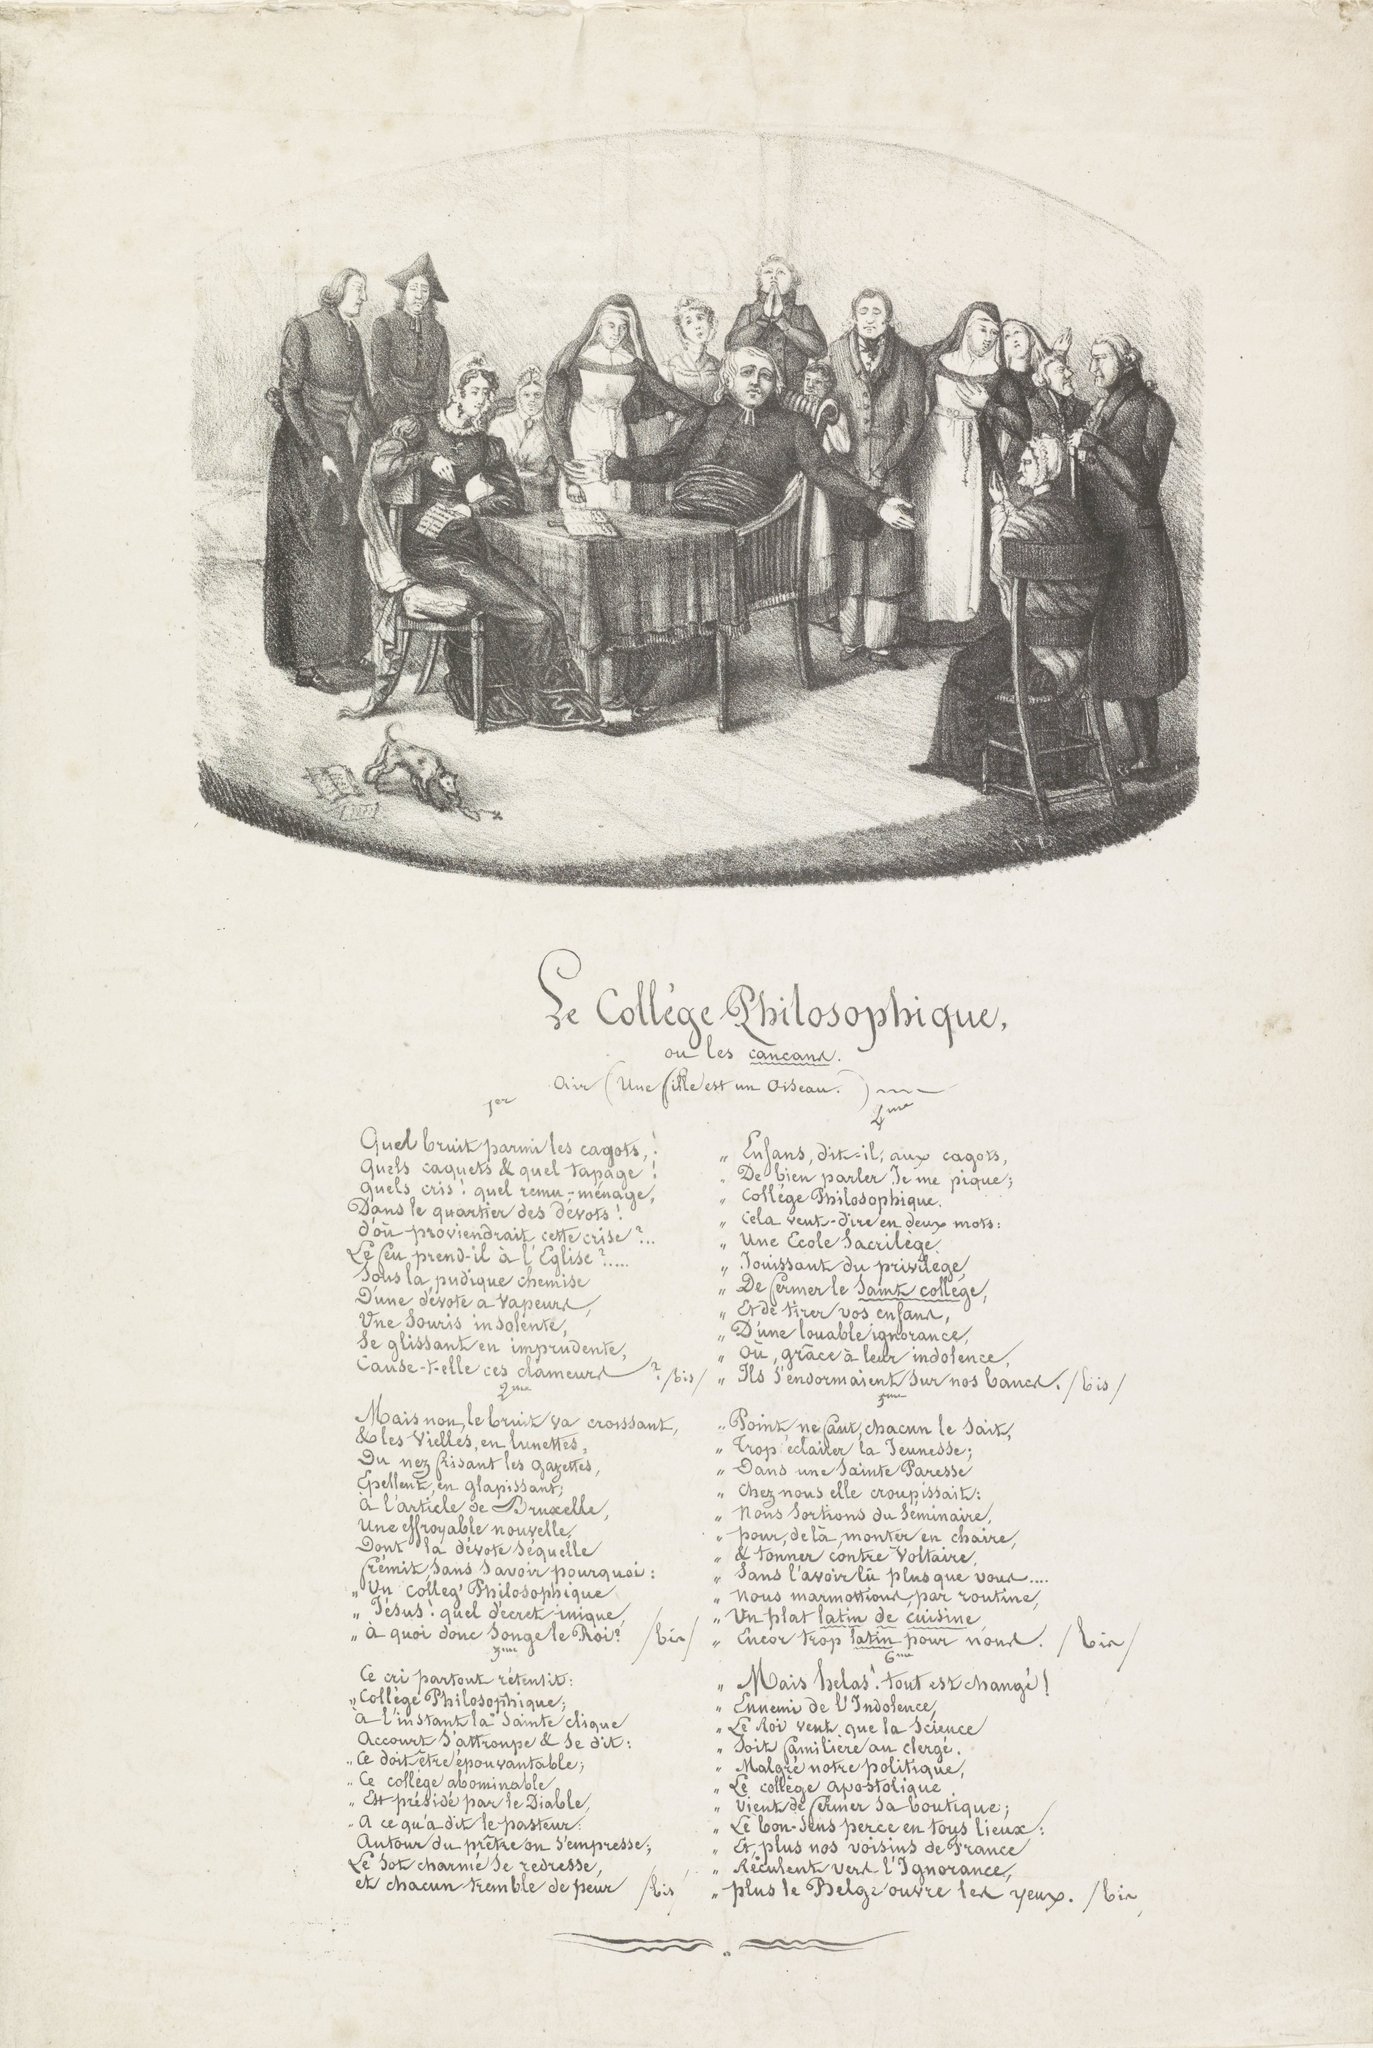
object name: print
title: Le Collège Philosophique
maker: Anonymous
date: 1825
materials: paper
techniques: lithograph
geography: southern netherlands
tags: berlin, william i of the netherlands, archbishop, bishop, etc. (roman catholic), louvain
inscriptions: collector's mark: Lugt 2228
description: Spotprent op de oprichting bij Koninklijk Besluit van 14 juni 1825 van het Collegium Philosophicum te Leuven, voor de opleiding van rooms-katholieke geestelijken. Als gevolg van dit besluit werden vele kleine seminaria opgeheven. Centraal zit de aartsbisschop van Mechelen, Franciscus Antonius de Méan de Beaurieux, aan een tafel omringd door devote mannen en vrouwen. De aartsbisschop spreidt zijn armen in een gebaar van hulpeloosheid of radeloosheid. Onder de voorstelling een Frans vers in zes coupletten.